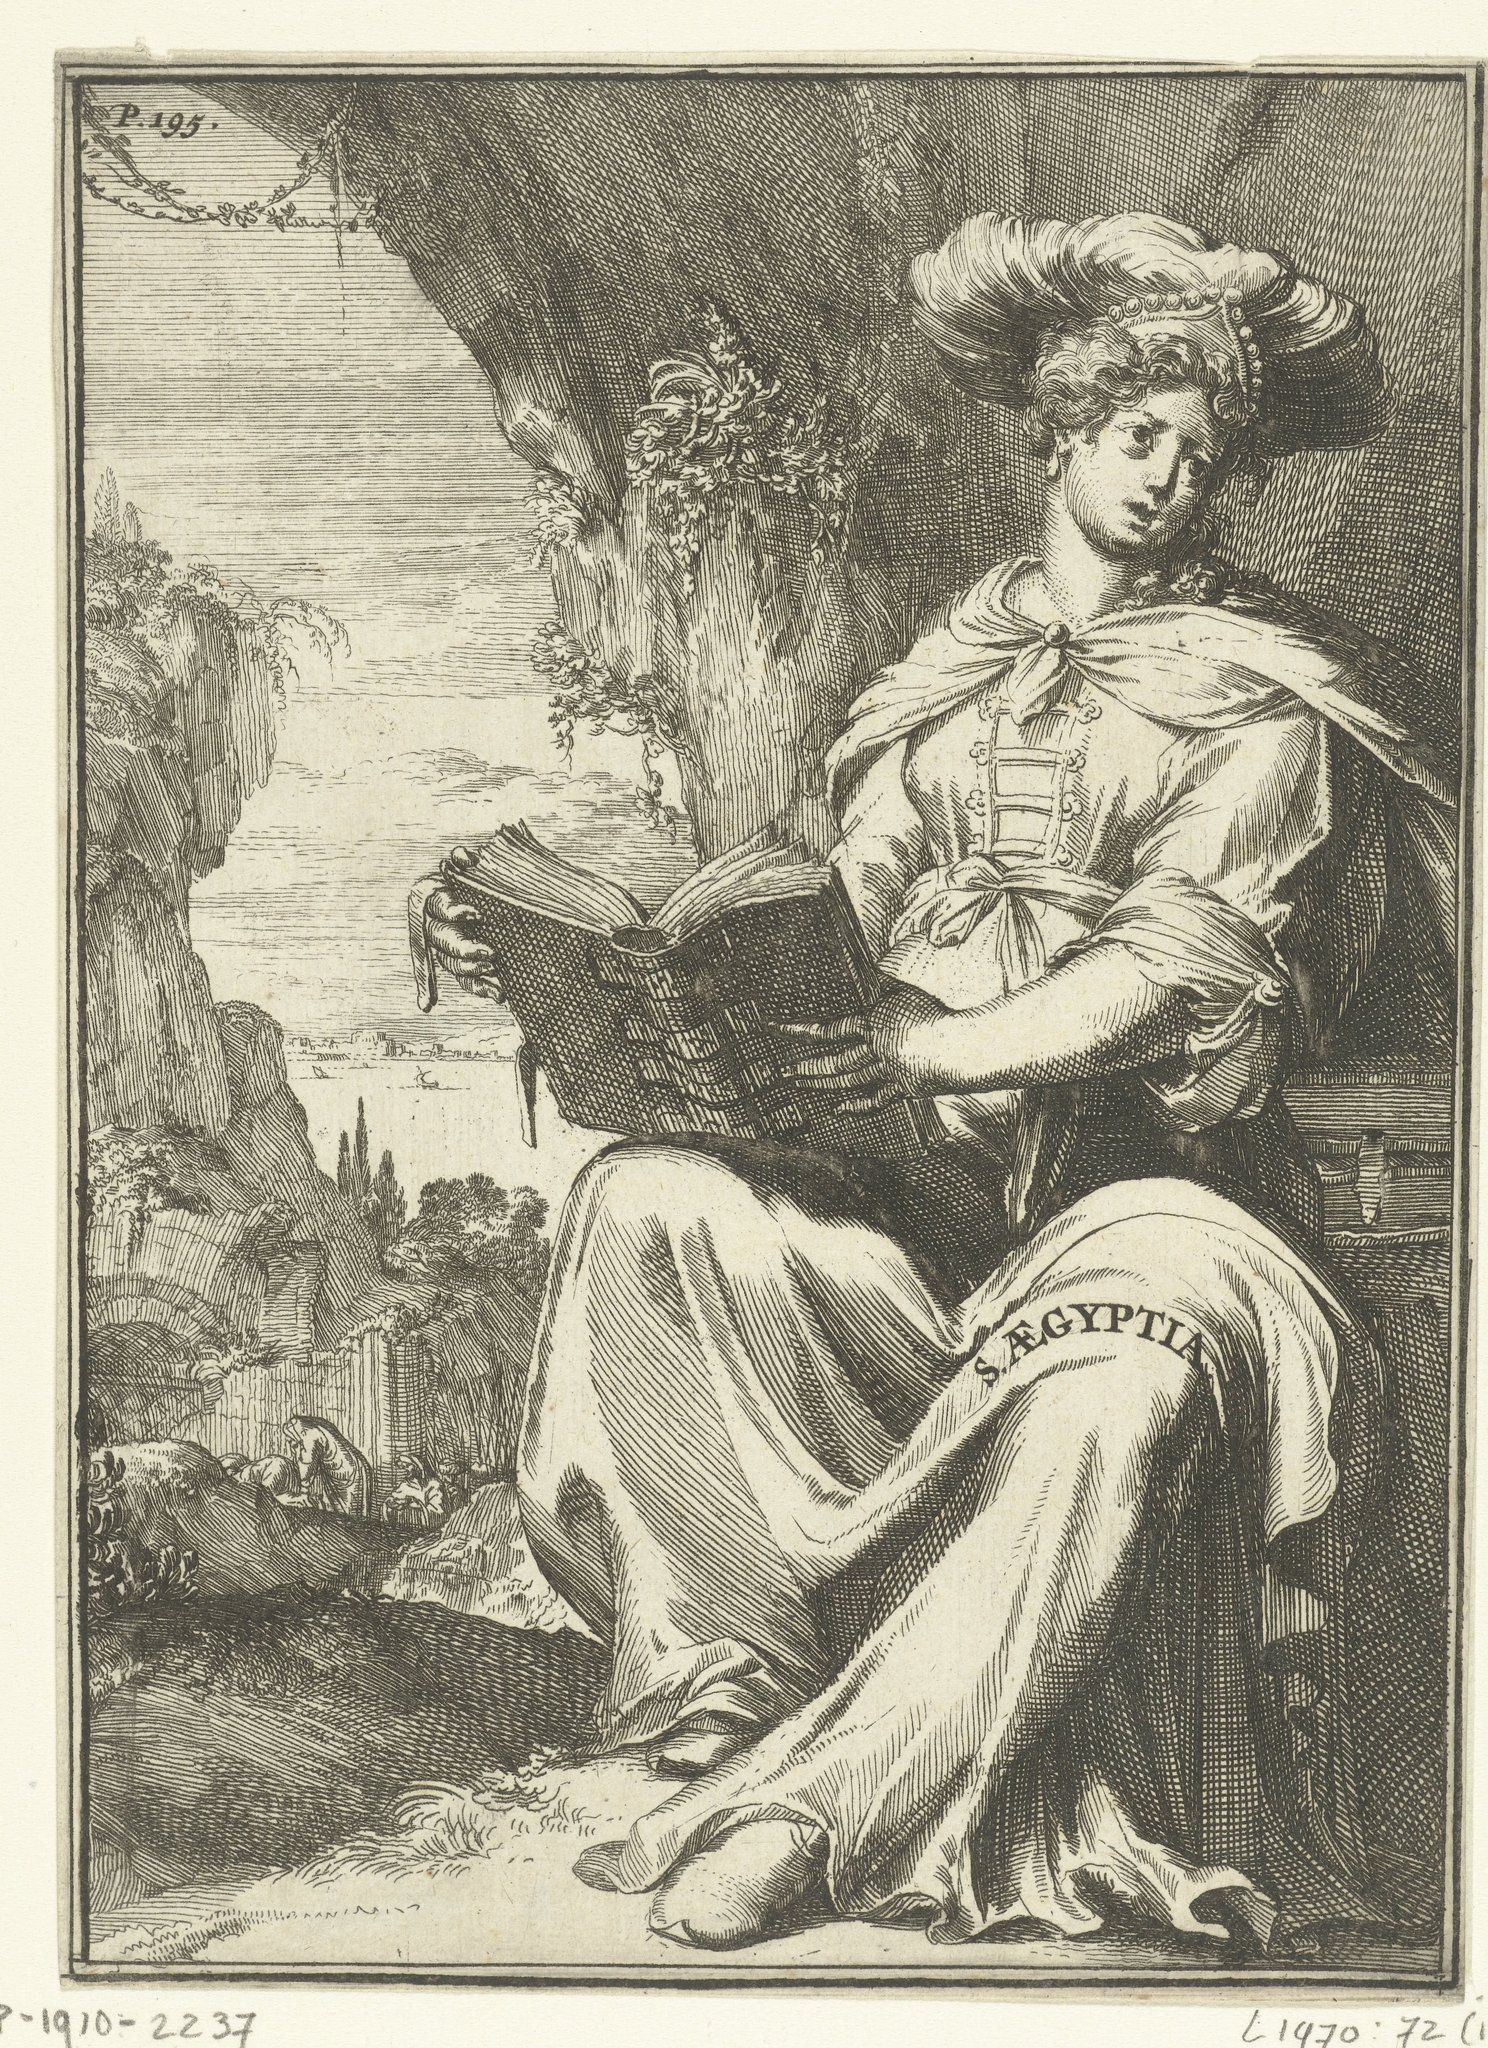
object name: book illustration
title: S. Aegyptia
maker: romeyn de hooghe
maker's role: draughtsman, goldsmith, painter, print maker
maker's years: 1645-1708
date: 1688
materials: paper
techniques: engraving, etching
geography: netherlands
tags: sibyls (with name)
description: Illustratie voor: Servatius Gallaeus, Dissertationes de Sibyllis, earumque oraculis, Amsterdam, Dirk en Hendrik Boom, 1688, p. 195.